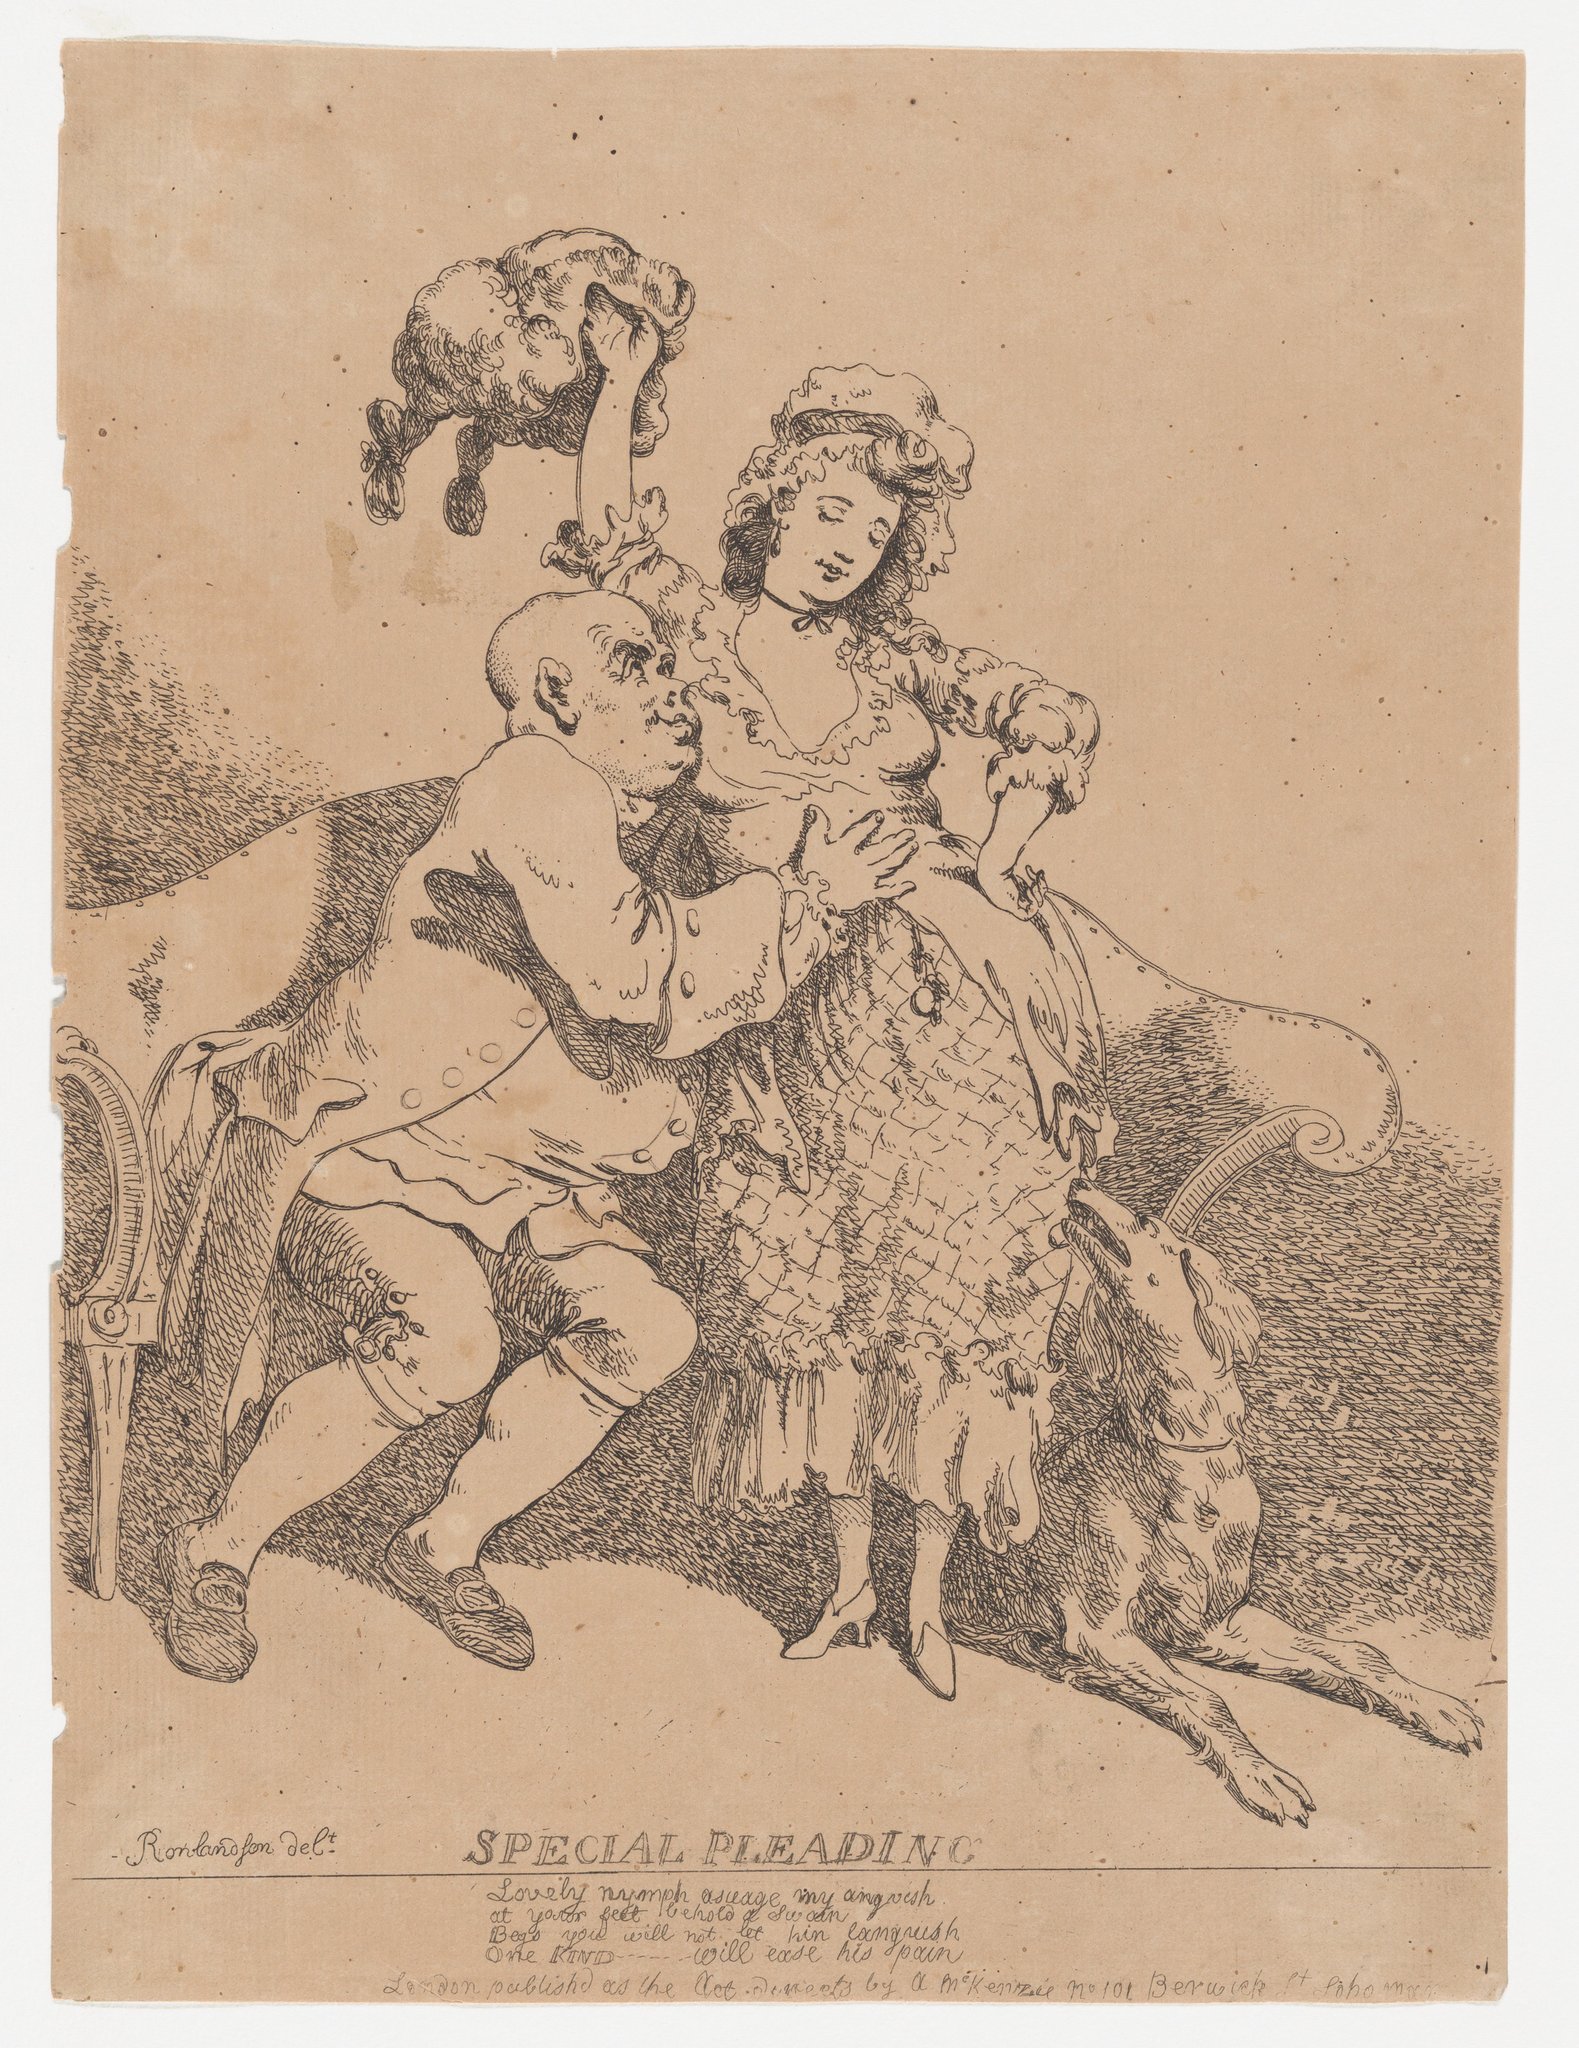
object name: print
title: Special Pleading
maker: thomas rowlandson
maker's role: artist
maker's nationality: british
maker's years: 1757-1827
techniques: etching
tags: men,women,dogs